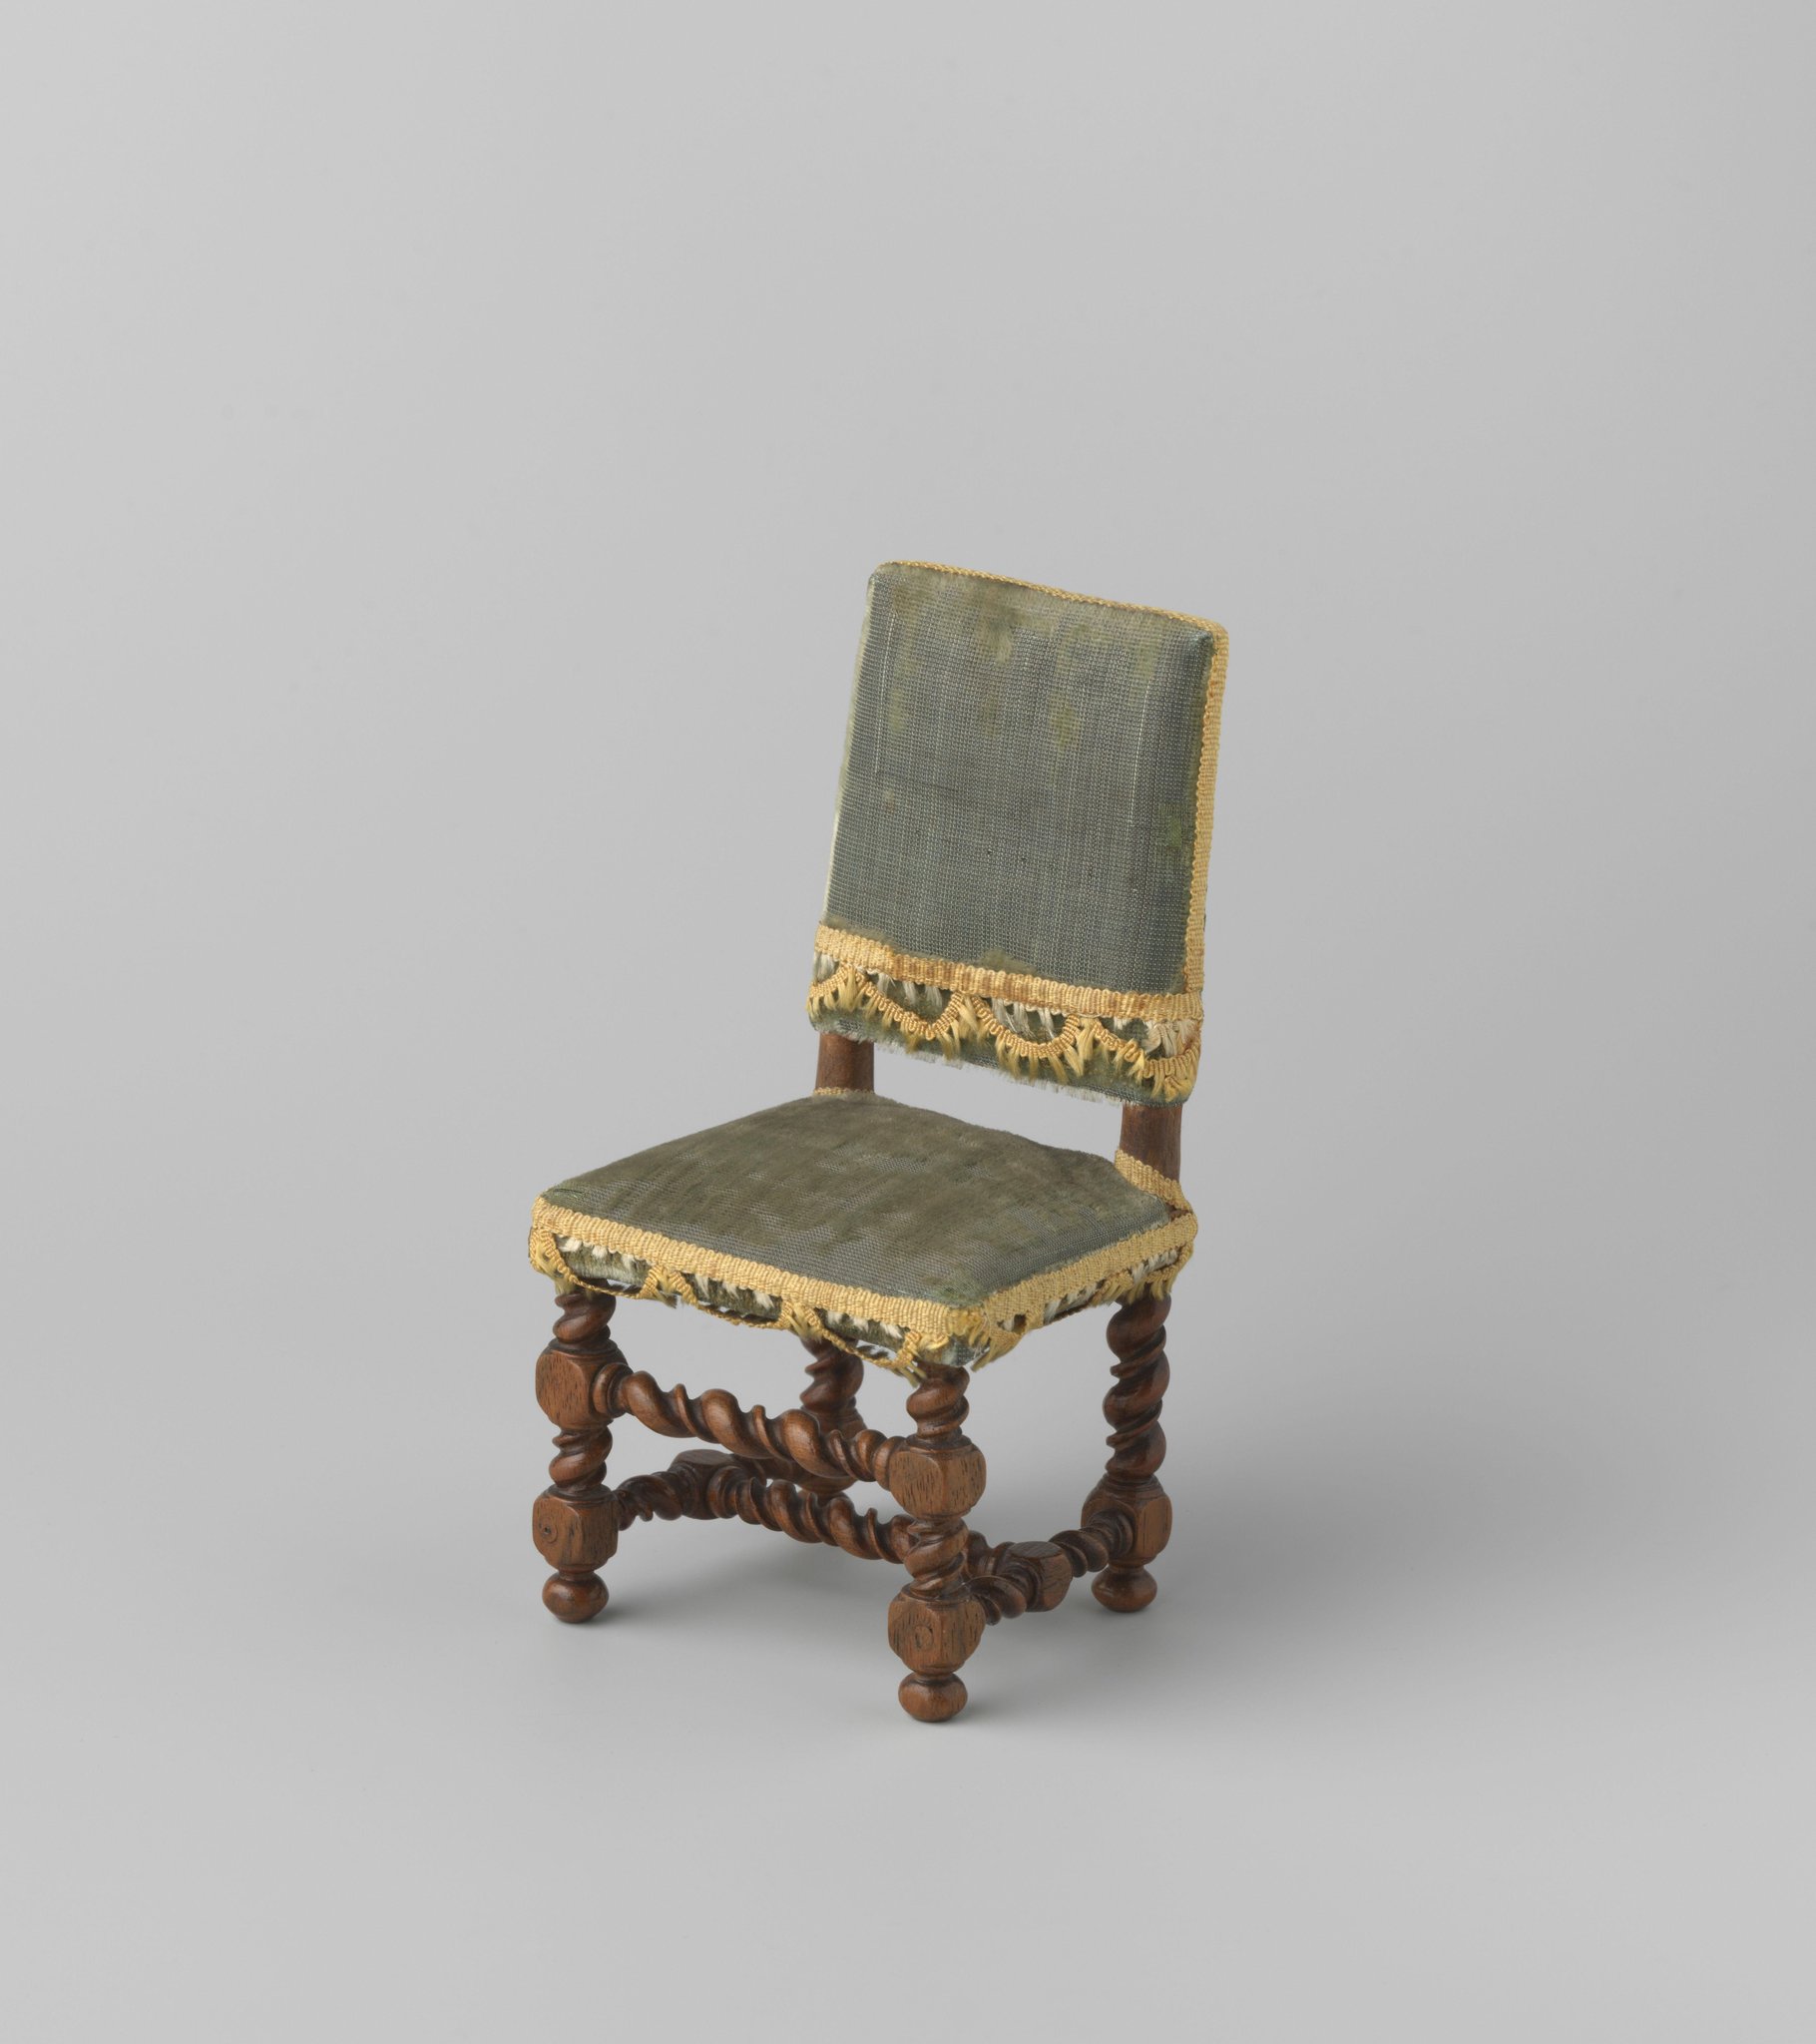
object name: leunstoel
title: Leunstoel met bekleding van zijdefluweel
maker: Anonymous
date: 1690-1710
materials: linen, board, silk, wood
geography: amsterdam